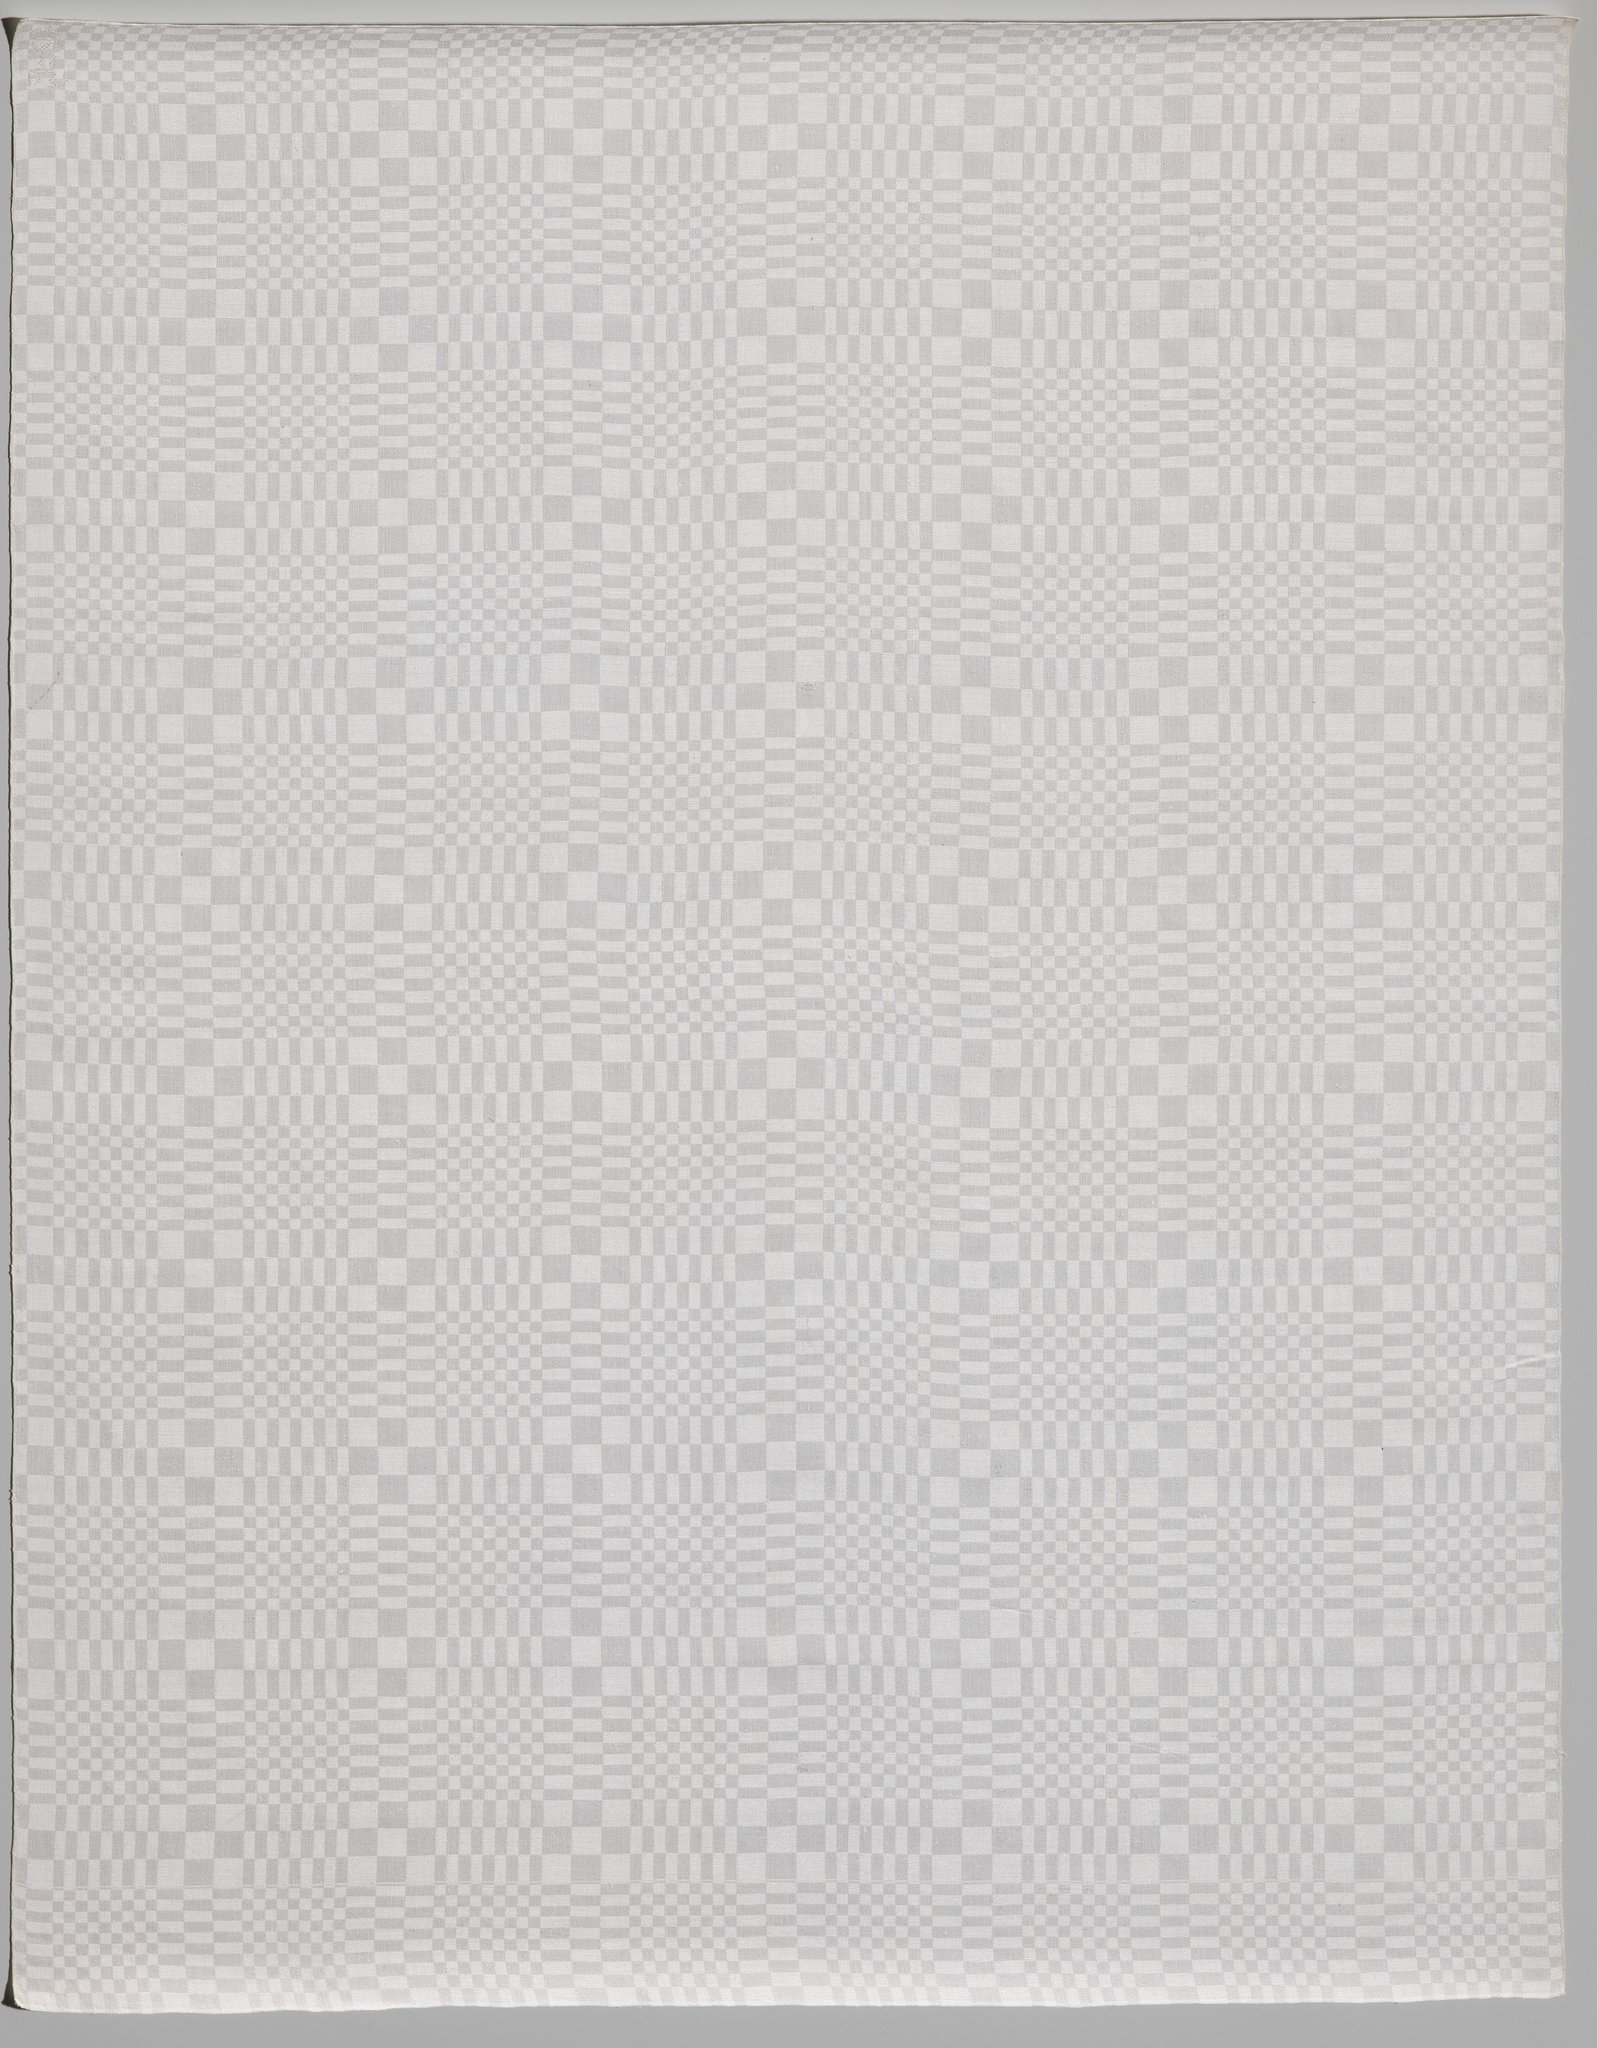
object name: napkin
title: Servet van pellendamast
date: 1739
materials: linen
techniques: weave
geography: northern netherlands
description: Wit linnen servet met pellenpatroon, genaamd "Engelse garderobe". Merk kroon WG 36 1739.